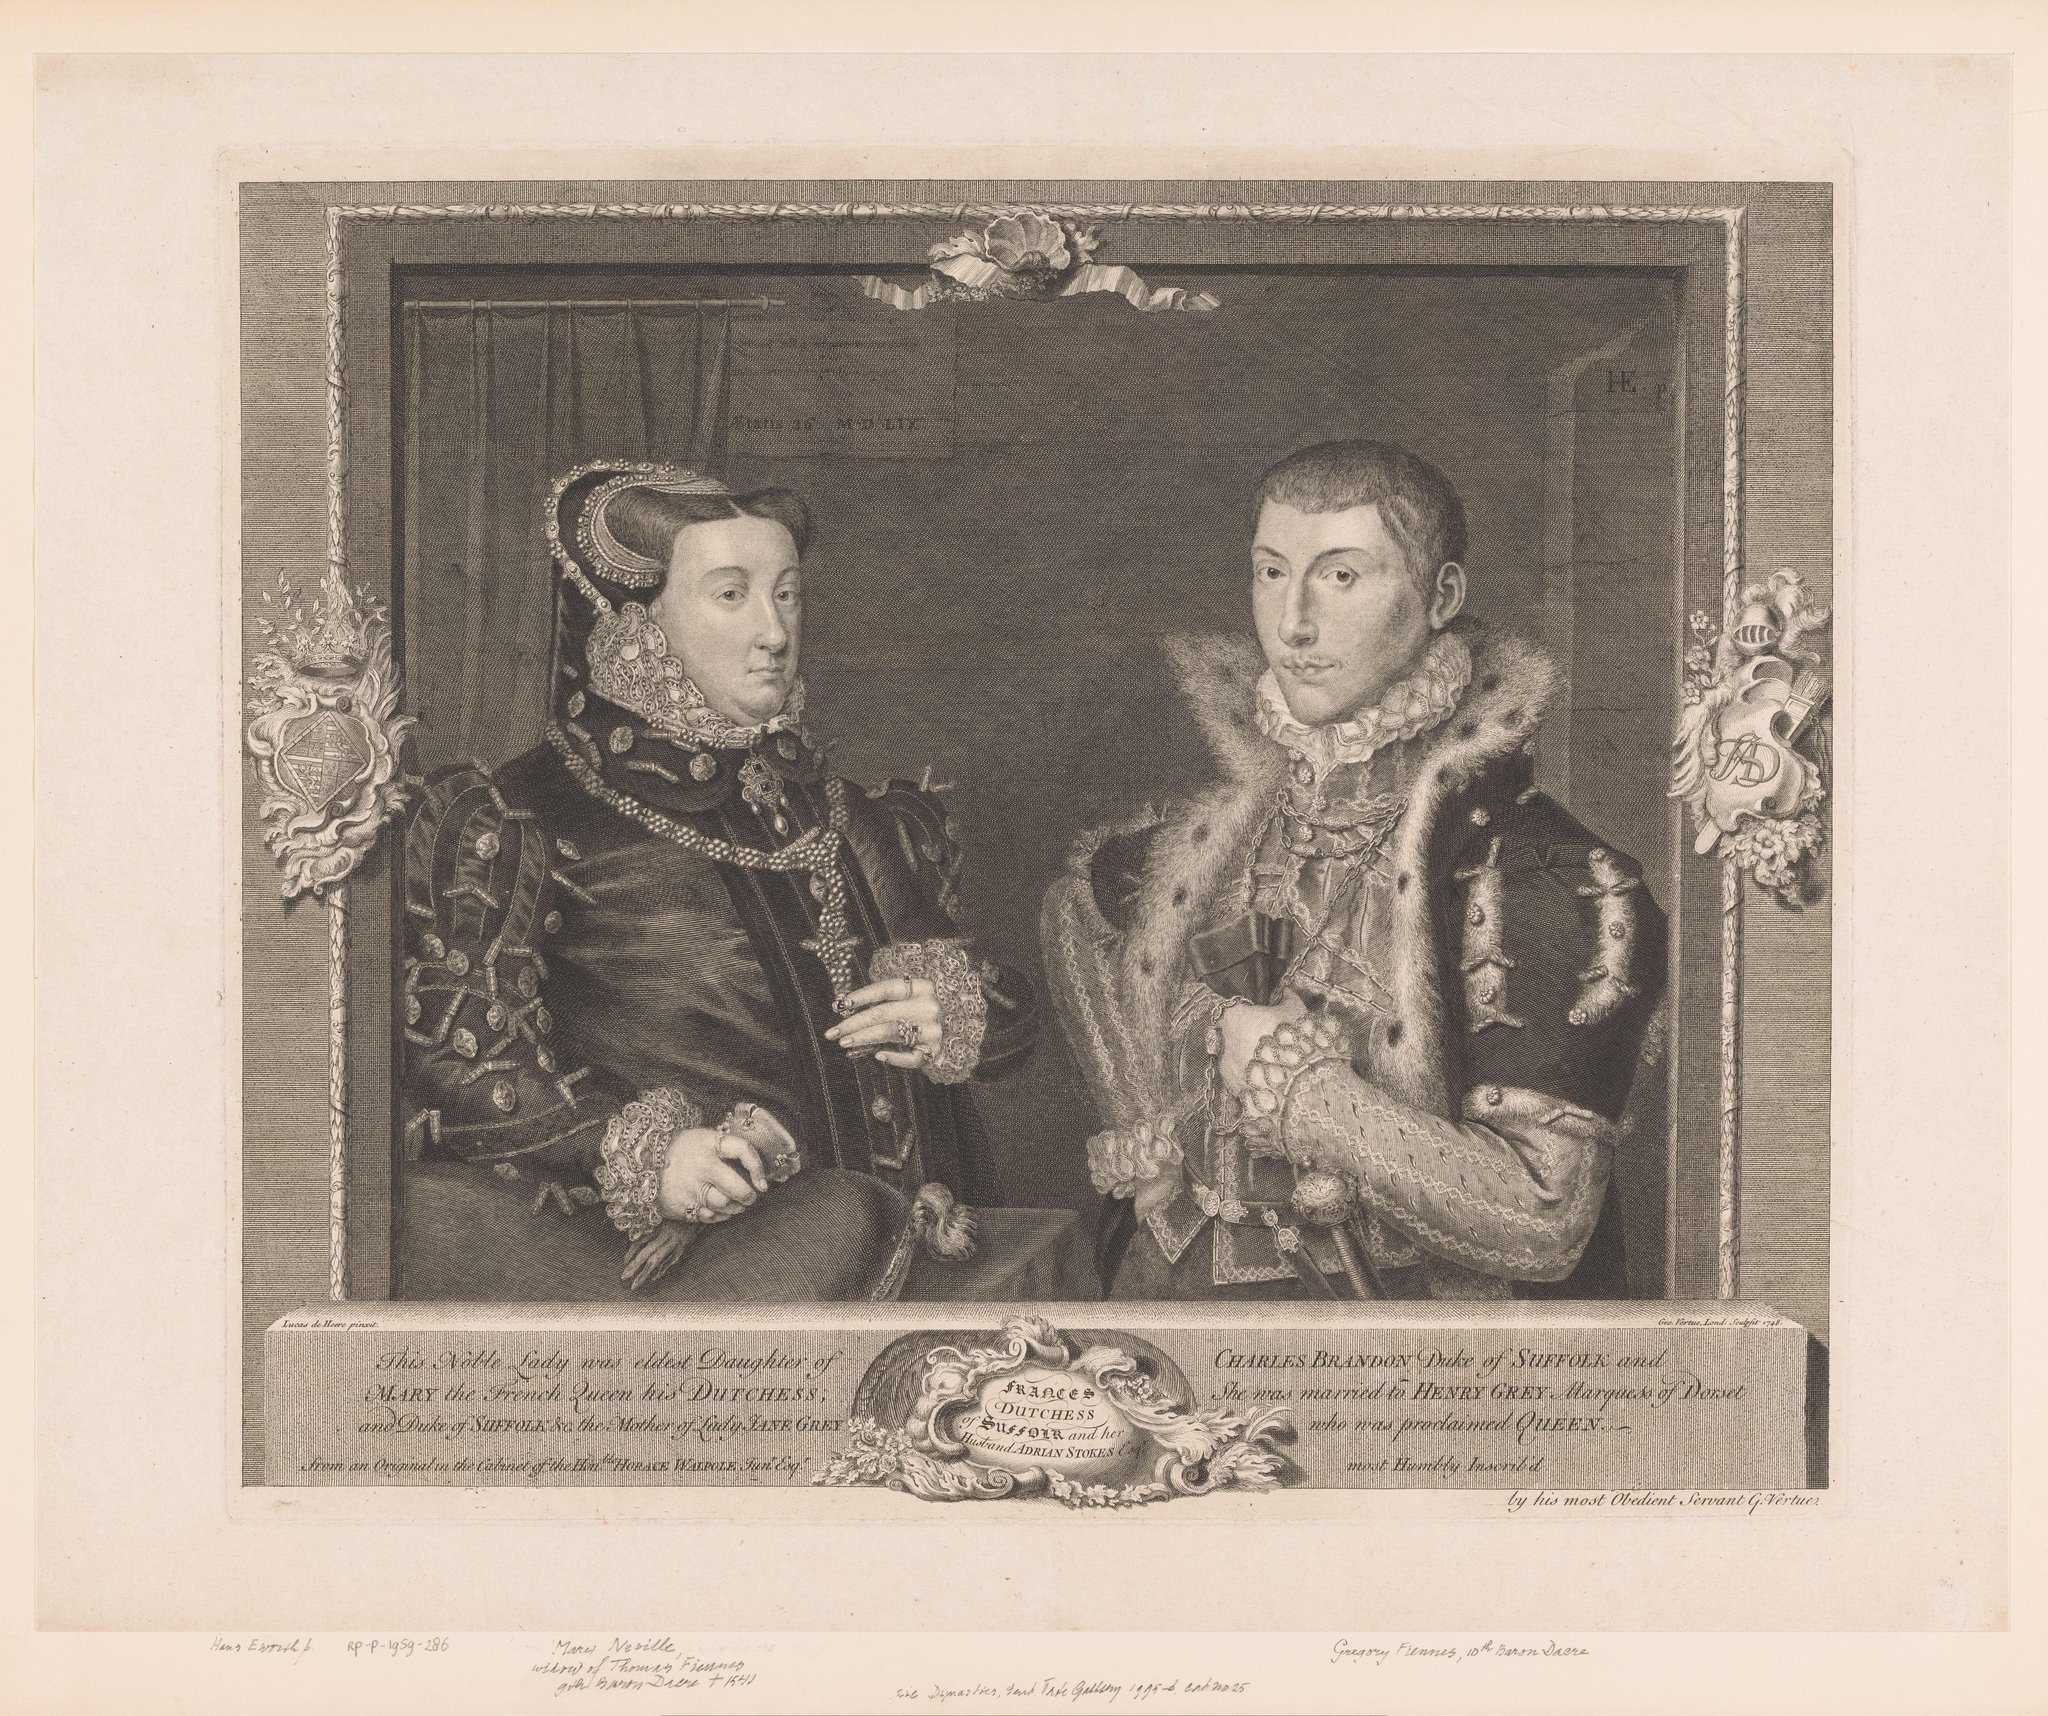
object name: print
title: Portretten van de Tudors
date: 1748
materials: paper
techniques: etching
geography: london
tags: mother and son(s) (family group), gloves, mittens, etc., historical person in a double portrait, historical person - woman - in a double portrait, necklace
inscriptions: collector's mark: Lugt 2760, collector's mark: Lugt 2228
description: Prent is naar een schilderij van Hans Ewouts en niet naar Lukas de Heere, zoals op de prent vermeld. Het portret is niet van Frances Brandon en haar tweede man Adrian Stokes, maar van Mary Fiennes en haar zoon Gregory Fiennes. Prent hoort bij een serie van negen prenten naar portretten van de Tudor-familie. De eerste vier werden in 1743 uitgegeven. In 1748 werden weer vier prenten gepubliceerd en in 1750 een laatste.